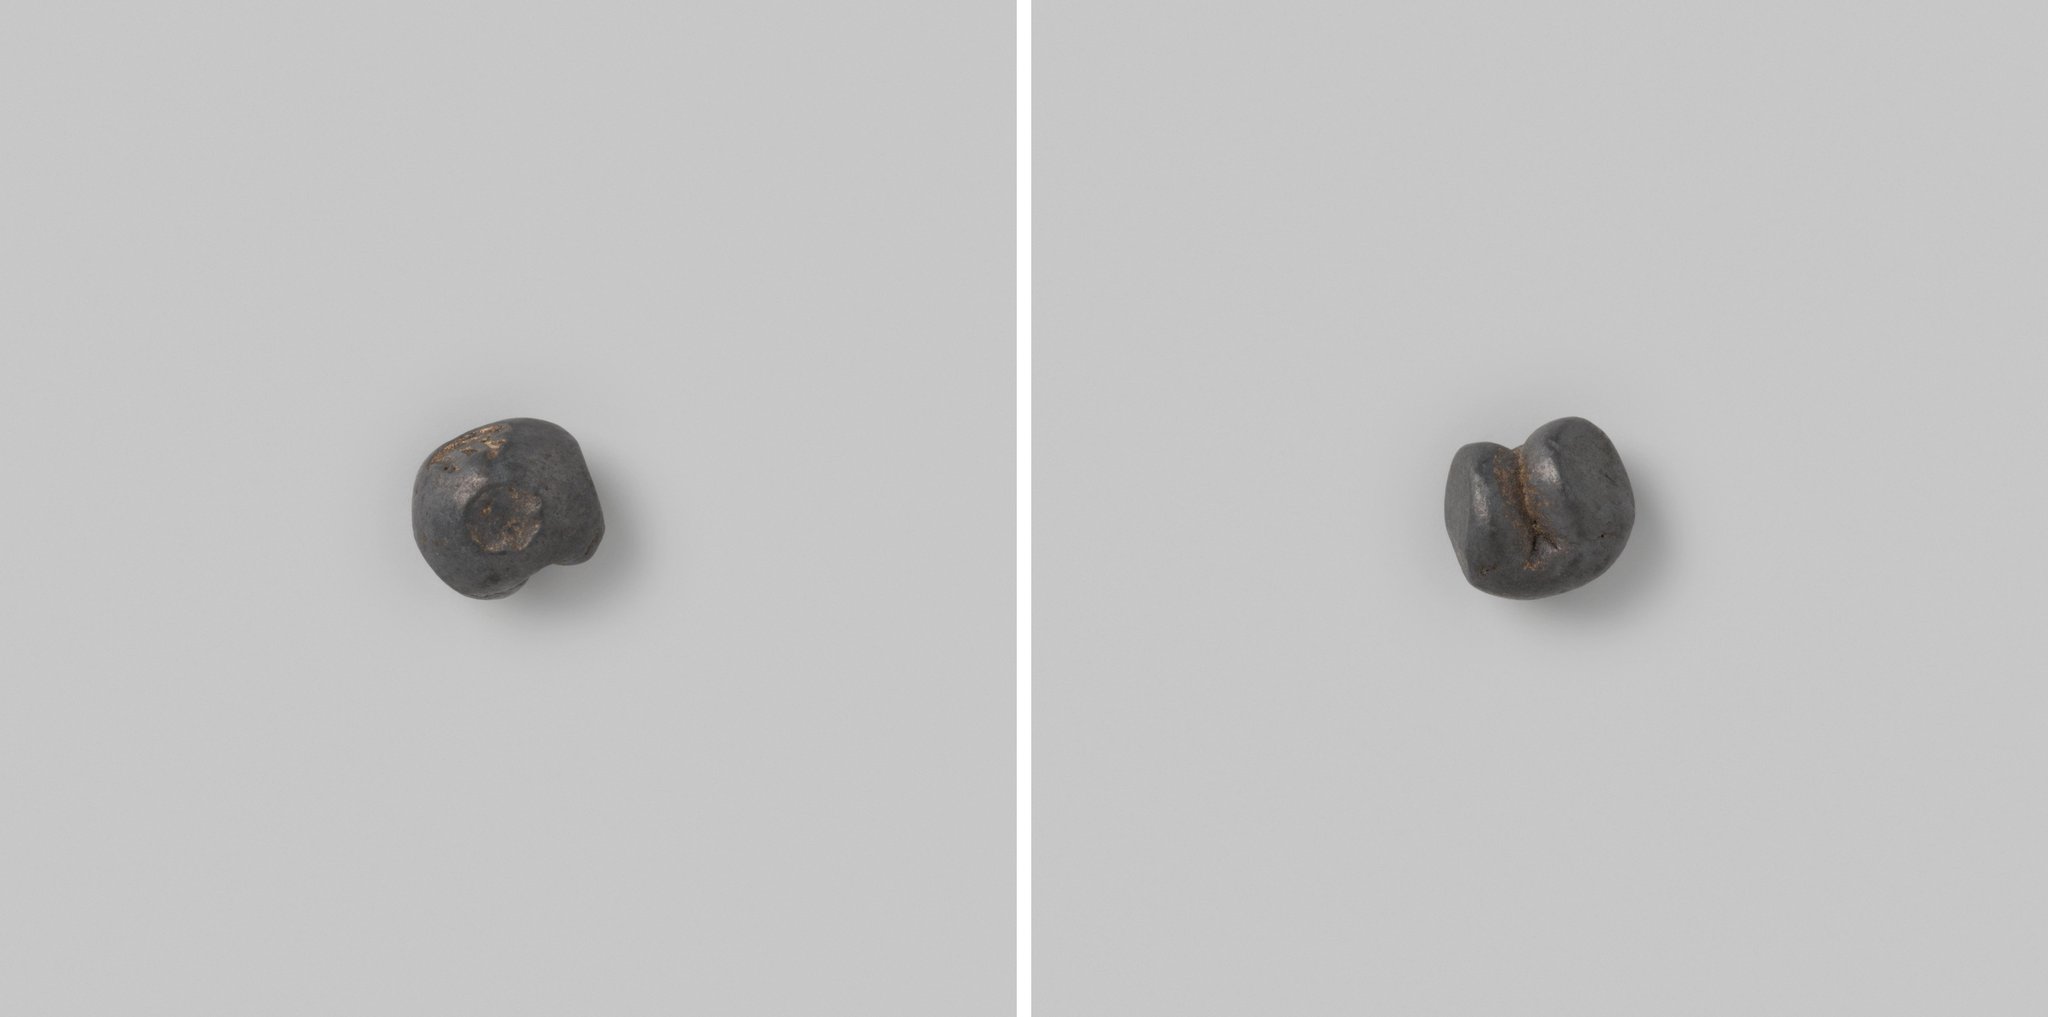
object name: coin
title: Thailand,1/16 tical of sik,1650-1850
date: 1650-1850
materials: silver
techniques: casting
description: Zilveren, korrelvormige munt. voorzien van één, onduidelijke instempeling (kra).